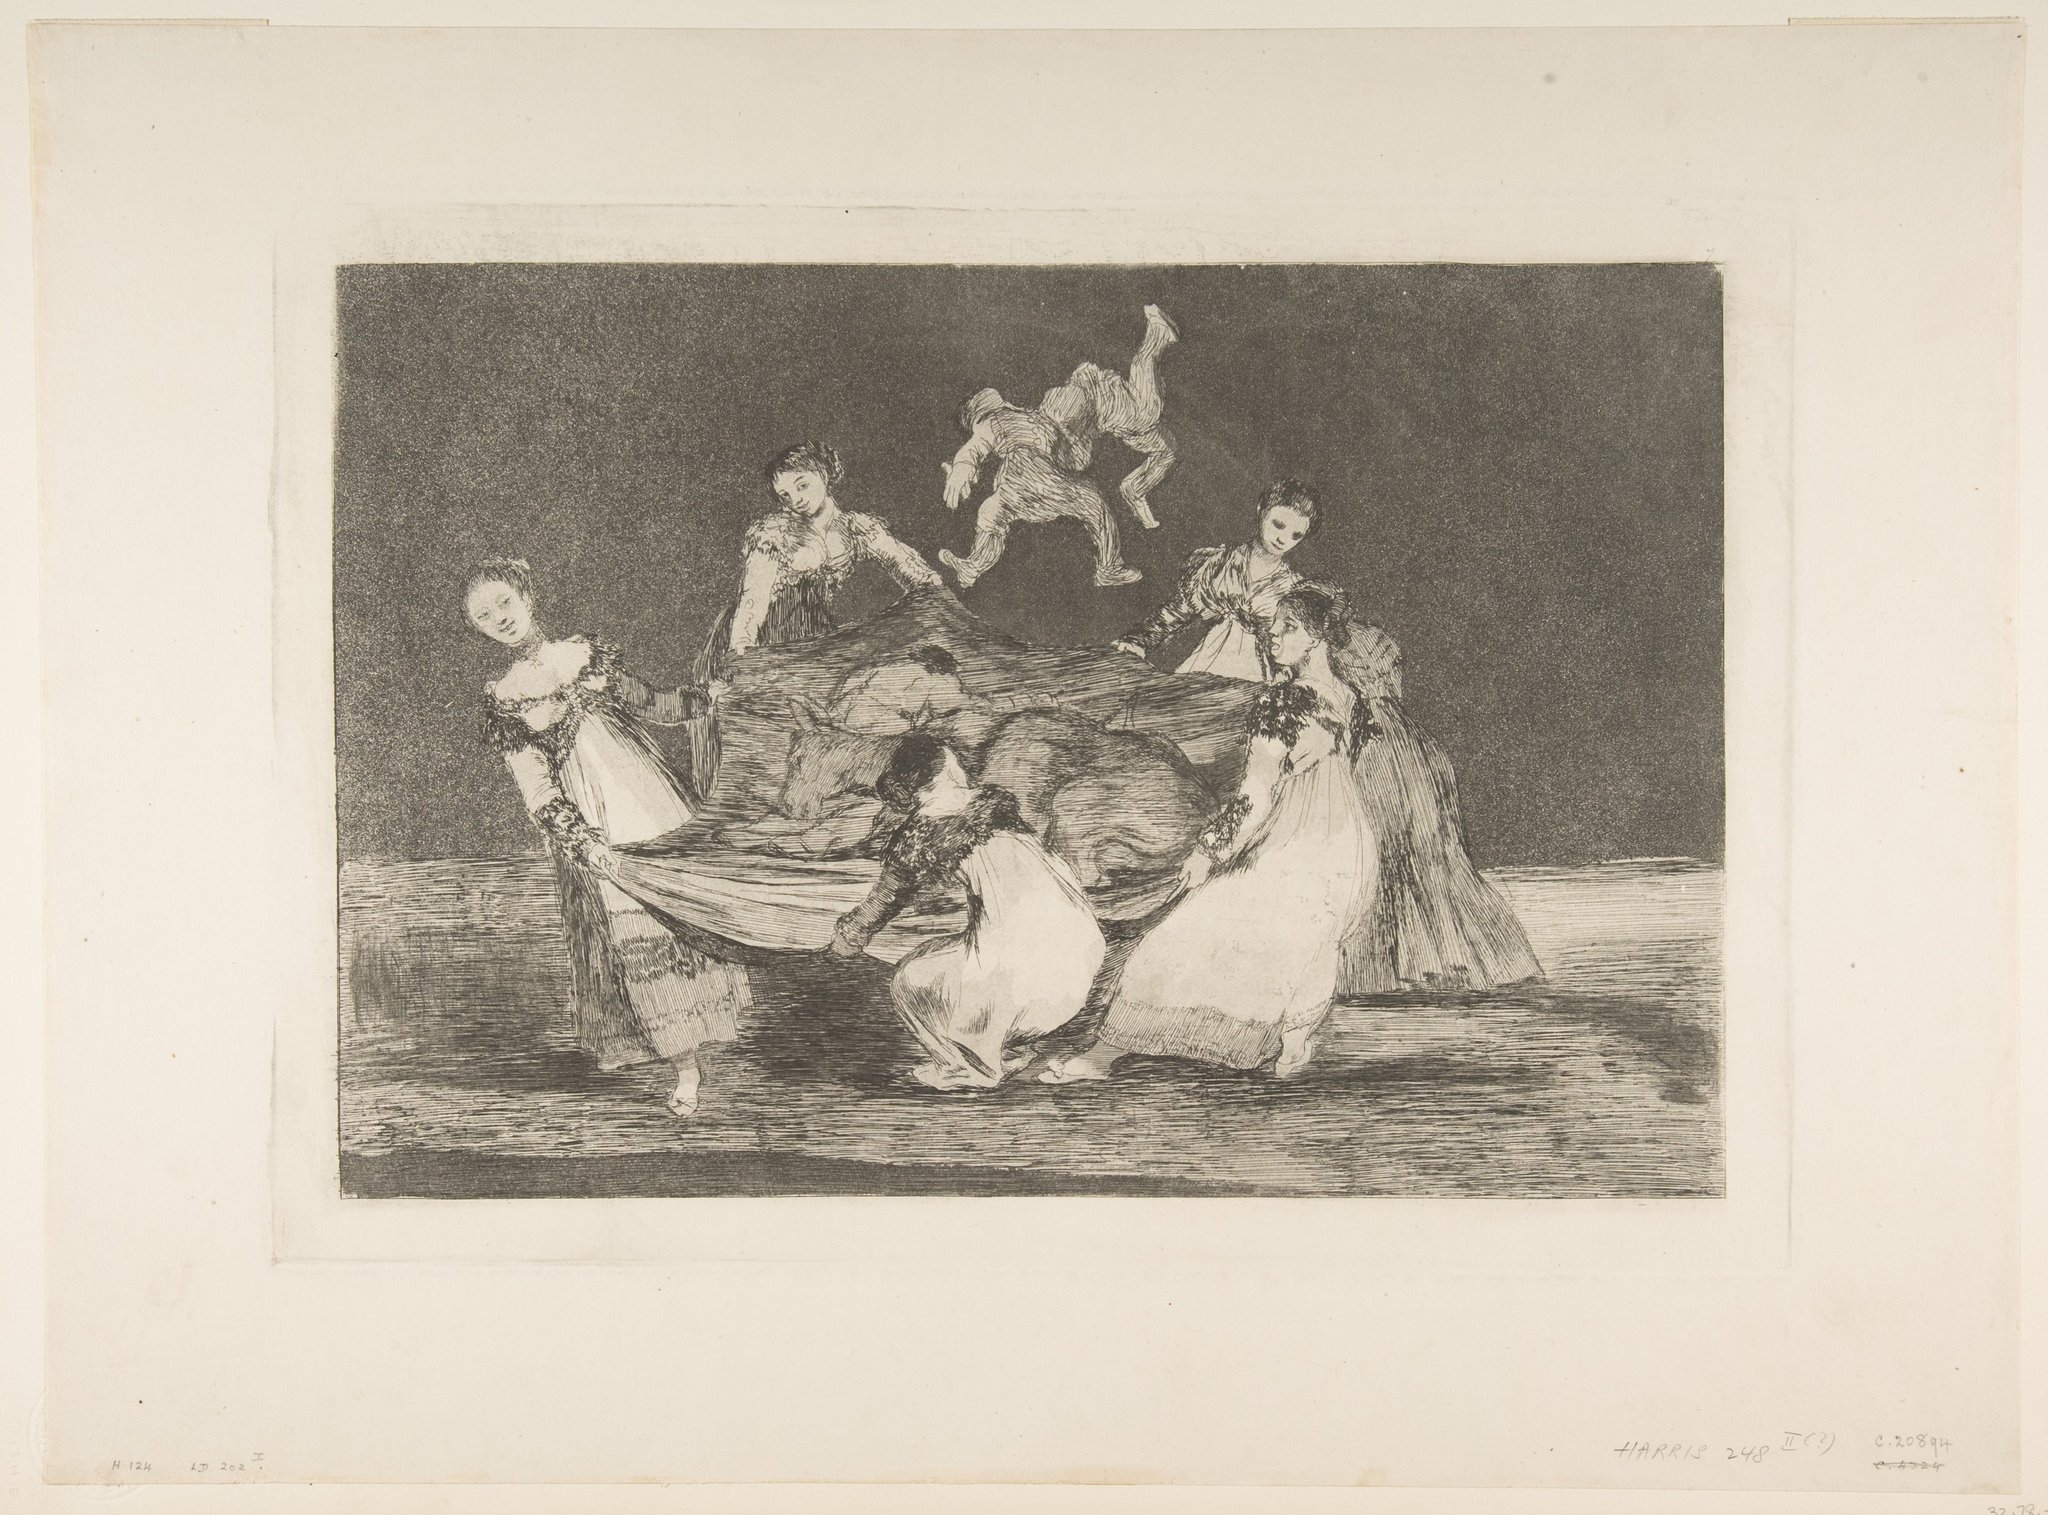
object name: print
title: 'Feminine Folly' from the 'Disparates' (Follies / Irrationalities)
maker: goya (francisco de goya y lucientes)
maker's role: artist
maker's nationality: spanish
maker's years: 1746-1828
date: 1815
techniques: aquatint, drypoint, etching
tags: animals,women,playing